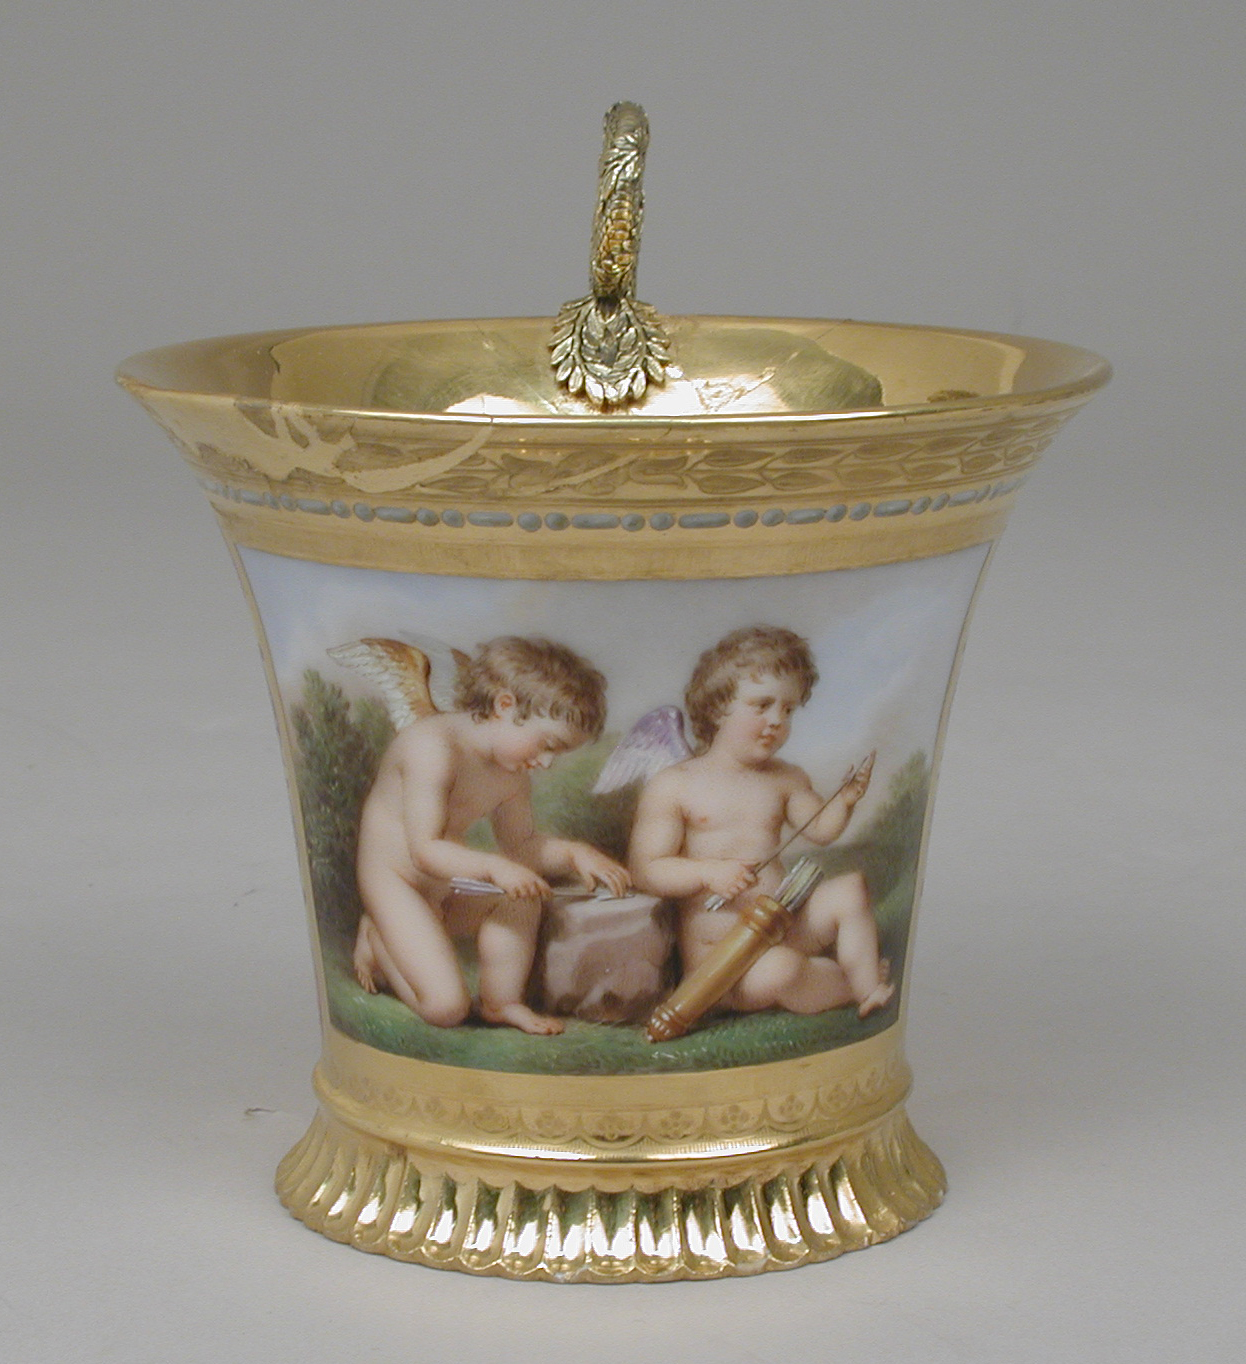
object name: cup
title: Cup (tasse Jasmin), part of Breakfast Service (déjeuner)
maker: sèvres manufactory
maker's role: manufactory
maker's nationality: french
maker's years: 1740-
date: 1813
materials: hard paste porcelain, silver gilt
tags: cupid